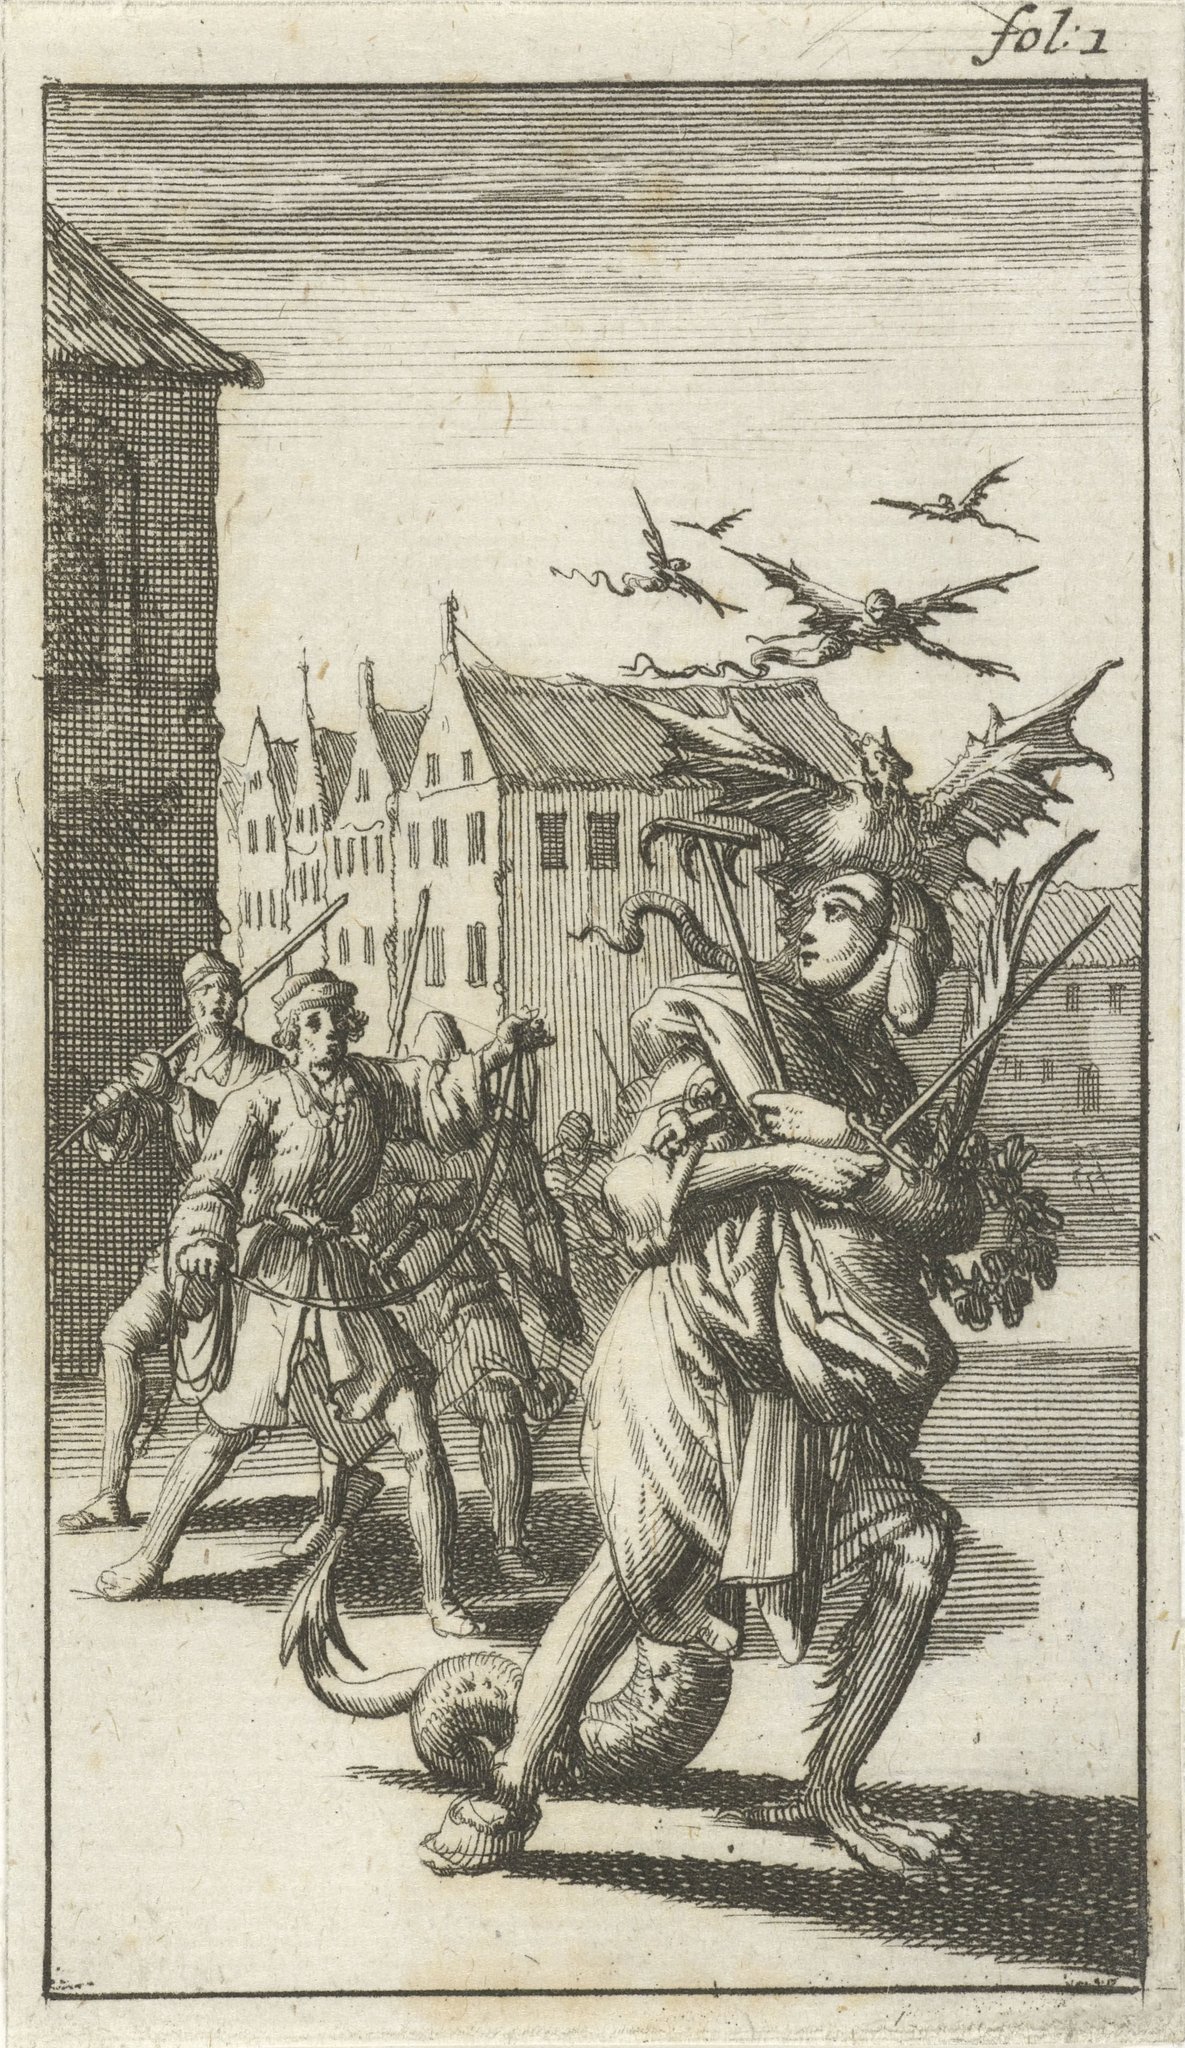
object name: book illustration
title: Zonde achtervolgd door drie mannen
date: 1687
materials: paper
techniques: etching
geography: amsterdam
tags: the seven deadly sins (personified)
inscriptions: collector's mark: Lugt 2228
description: Illustratie uit: Bernard, Richard. Het menschen-eyland, ofte Rechts-pligtige procedure tegens de sonde, in't raad-huys van 'smenschen-herte. Amsterdam: Abraham Boekholt, 1686.